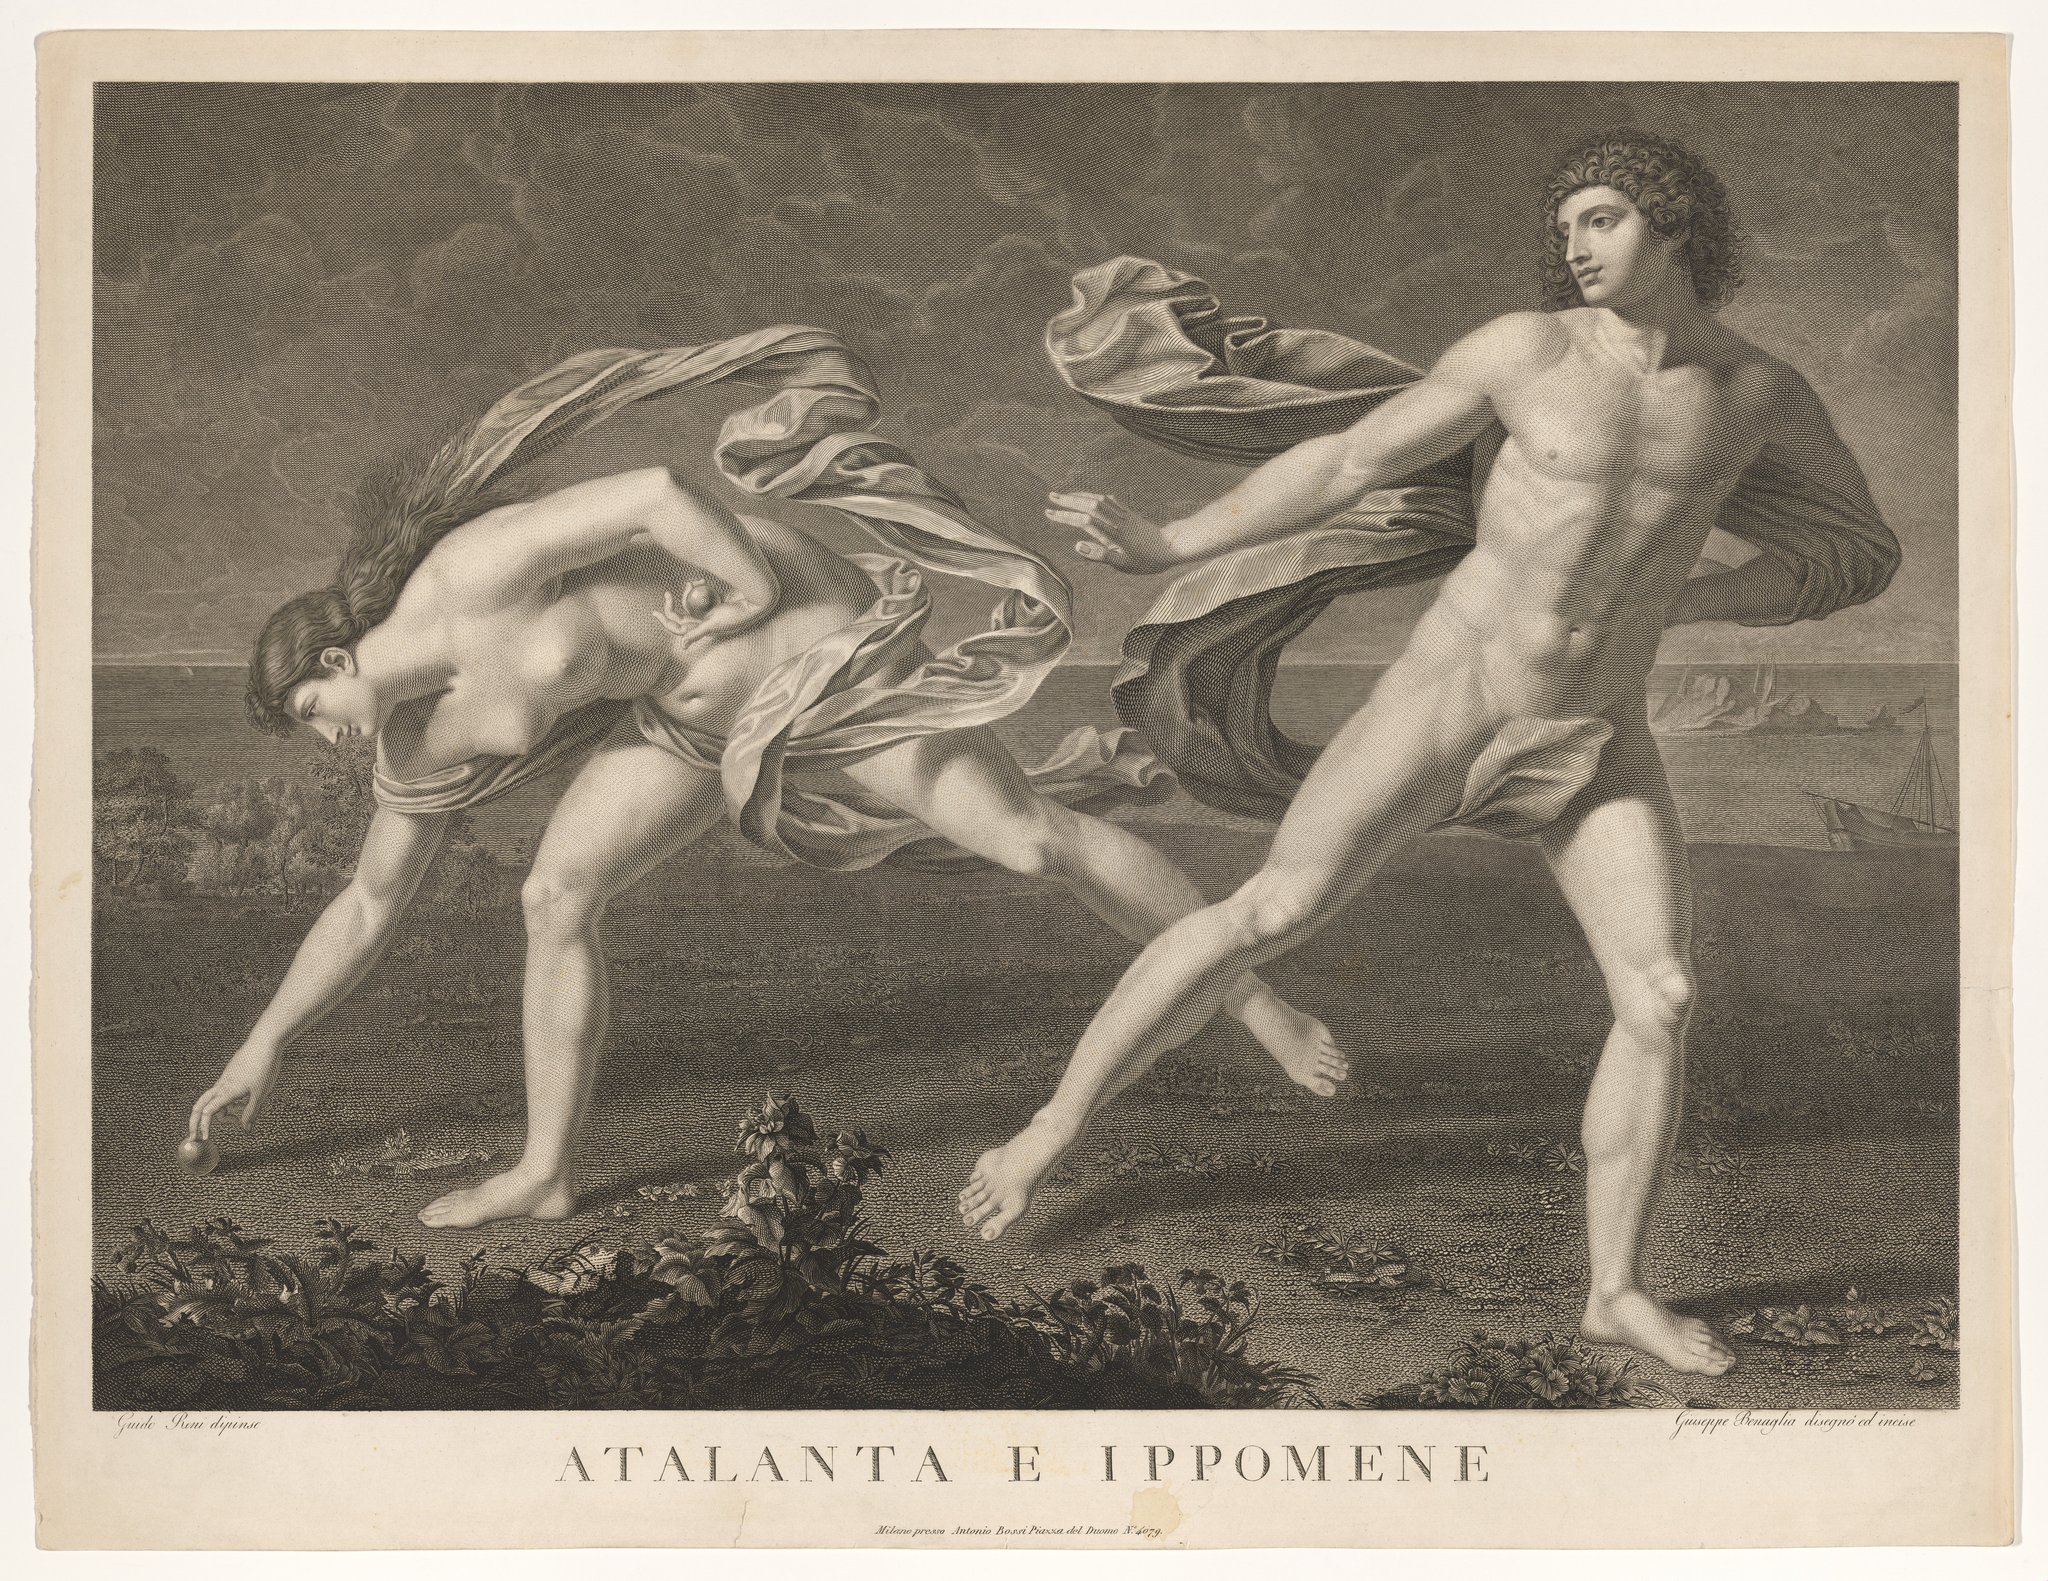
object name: print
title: Atalanta at left picking up the golden apple dropped by Hippomenes at right, after Reni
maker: giuseppe benaglia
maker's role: artist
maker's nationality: italian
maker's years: 1766-1835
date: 1815-1830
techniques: engraving